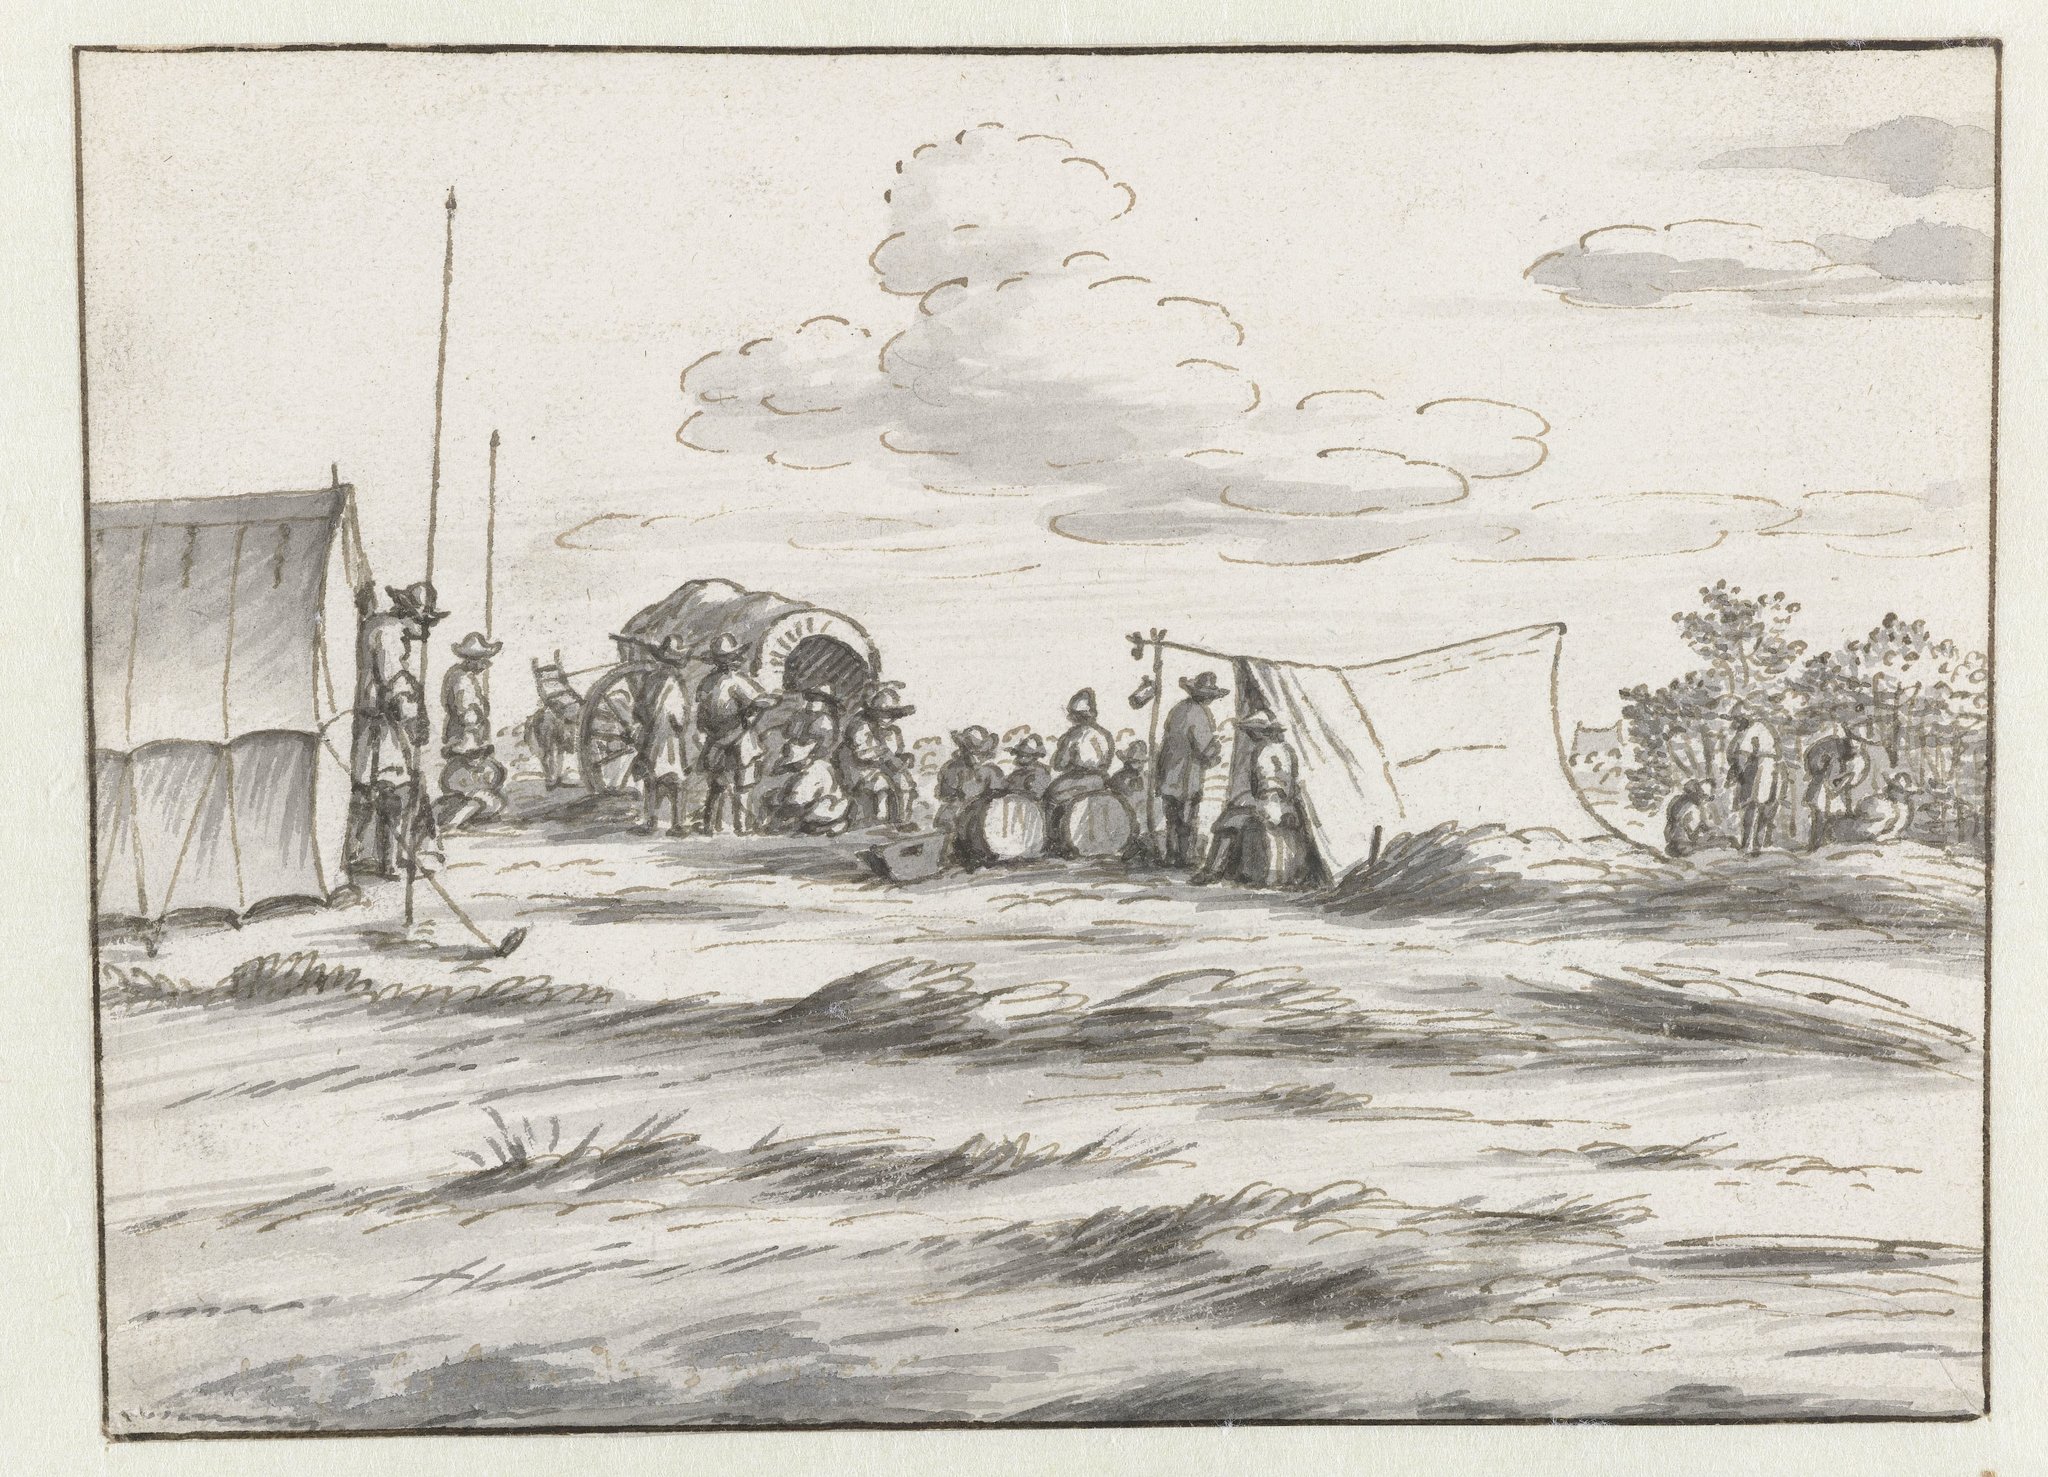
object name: drawing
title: View of an Encampment of the Army of Willem III near Leuven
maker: josua de grave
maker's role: draughtsman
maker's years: 1645-1712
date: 1675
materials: ink, paper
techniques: brush, pen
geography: leuven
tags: the hague, william iii (prince of orange and king of england, scotland, and ireland), (military) camp with tents, louvain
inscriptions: date: ‘16 7/17 75’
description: Kampement van het leger van Willem III bij Leuven, 17 juli 1675. Soldaten bij tenten.